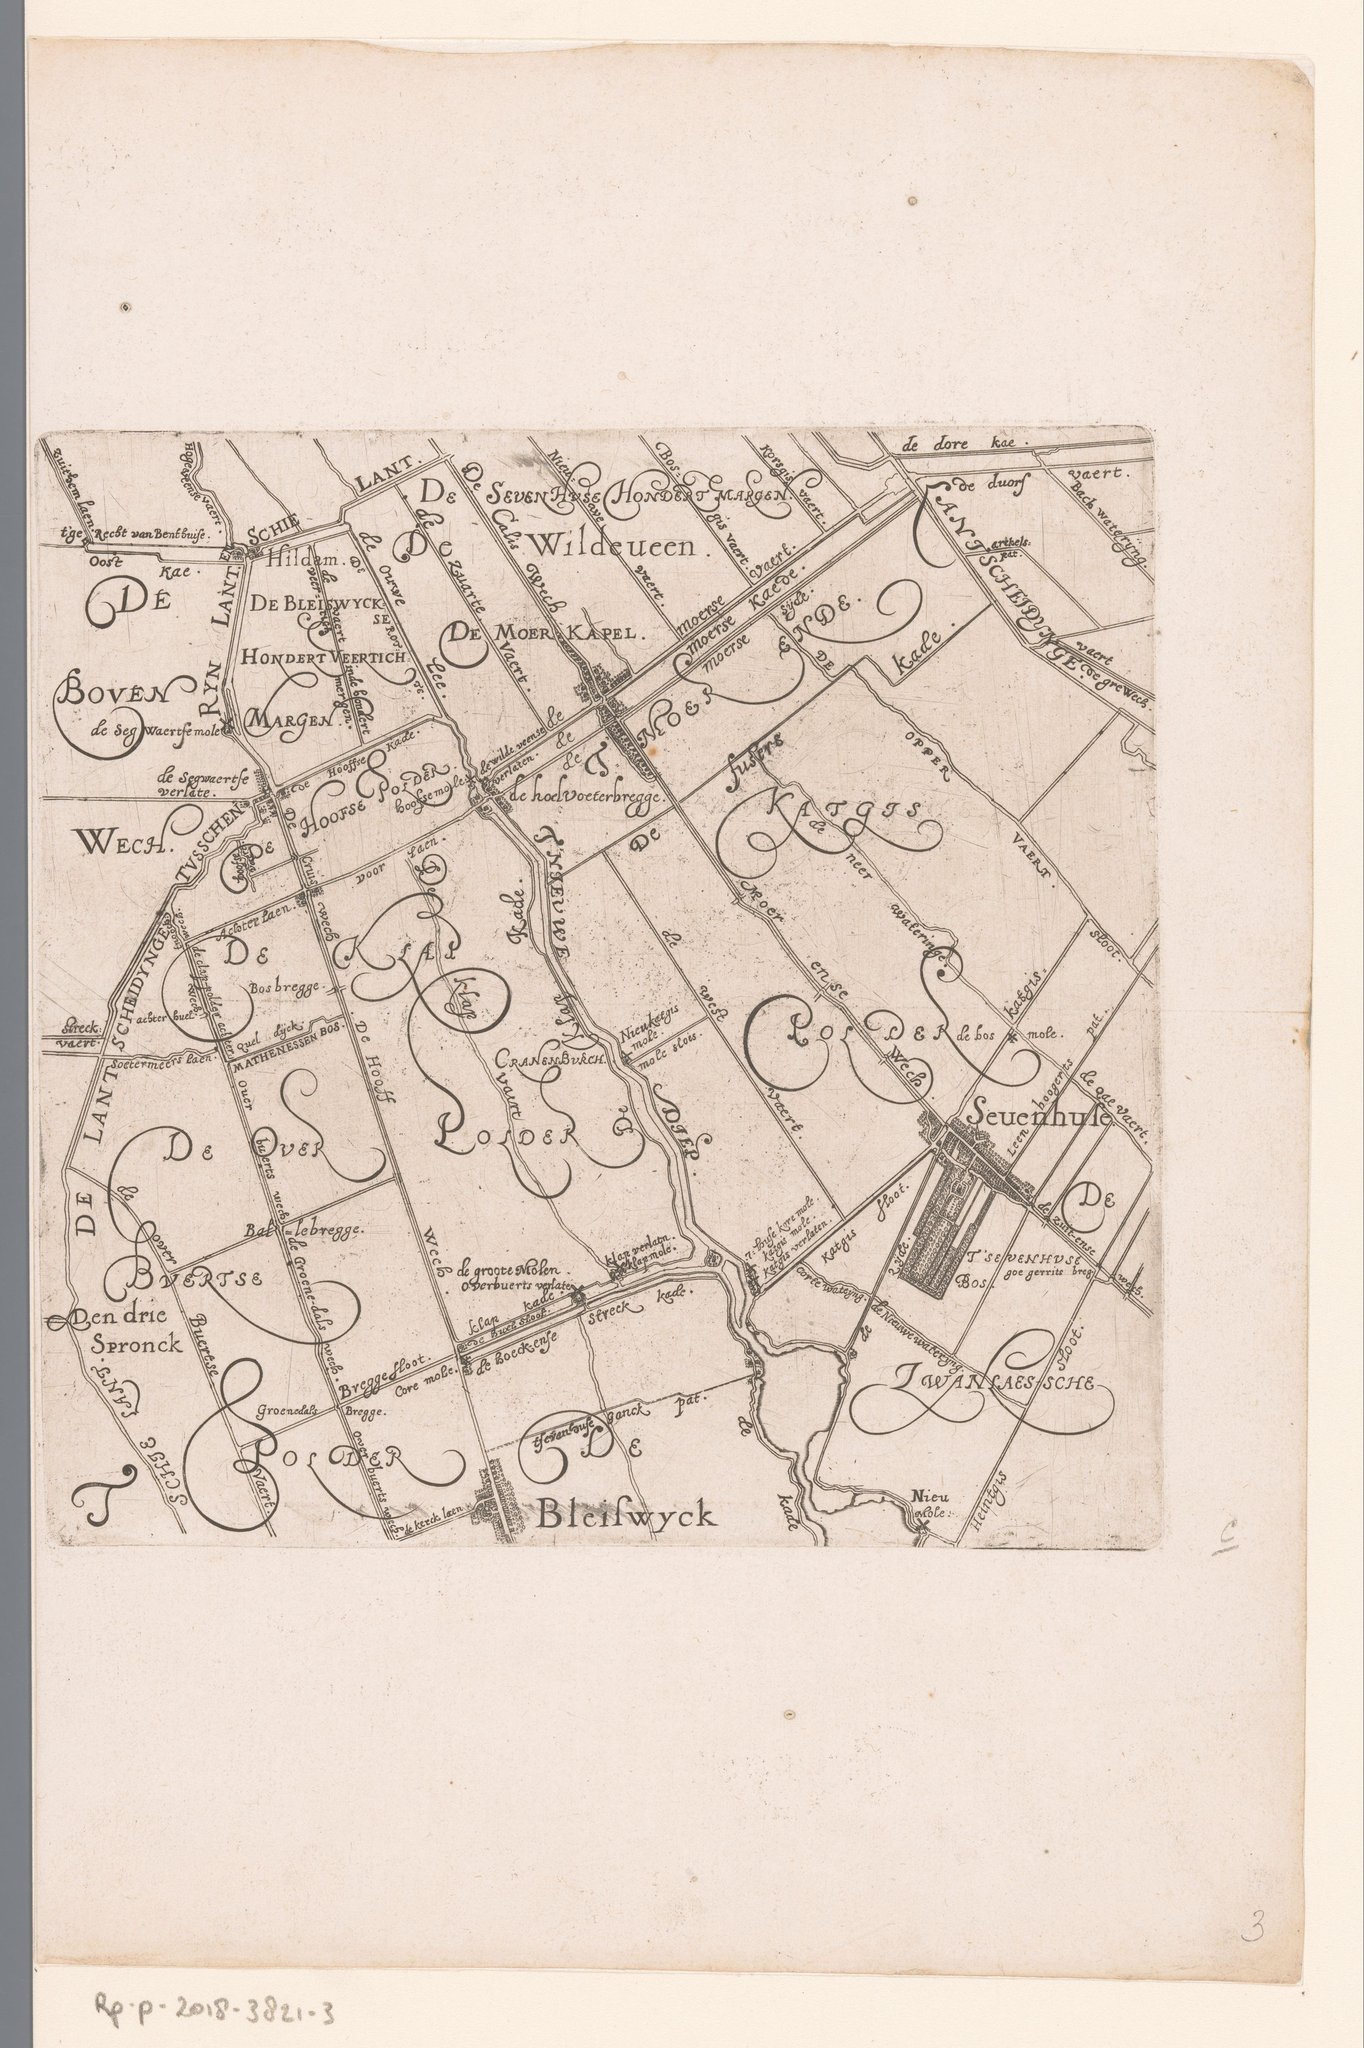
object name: print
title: Kaart van het Hoogheemraadschap van Delfland, met Zevenhuizen en Bleiswijk, deel rechtsboven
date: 1611-1692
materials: paper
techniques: engraving, etching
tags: maps of separate countries or regions